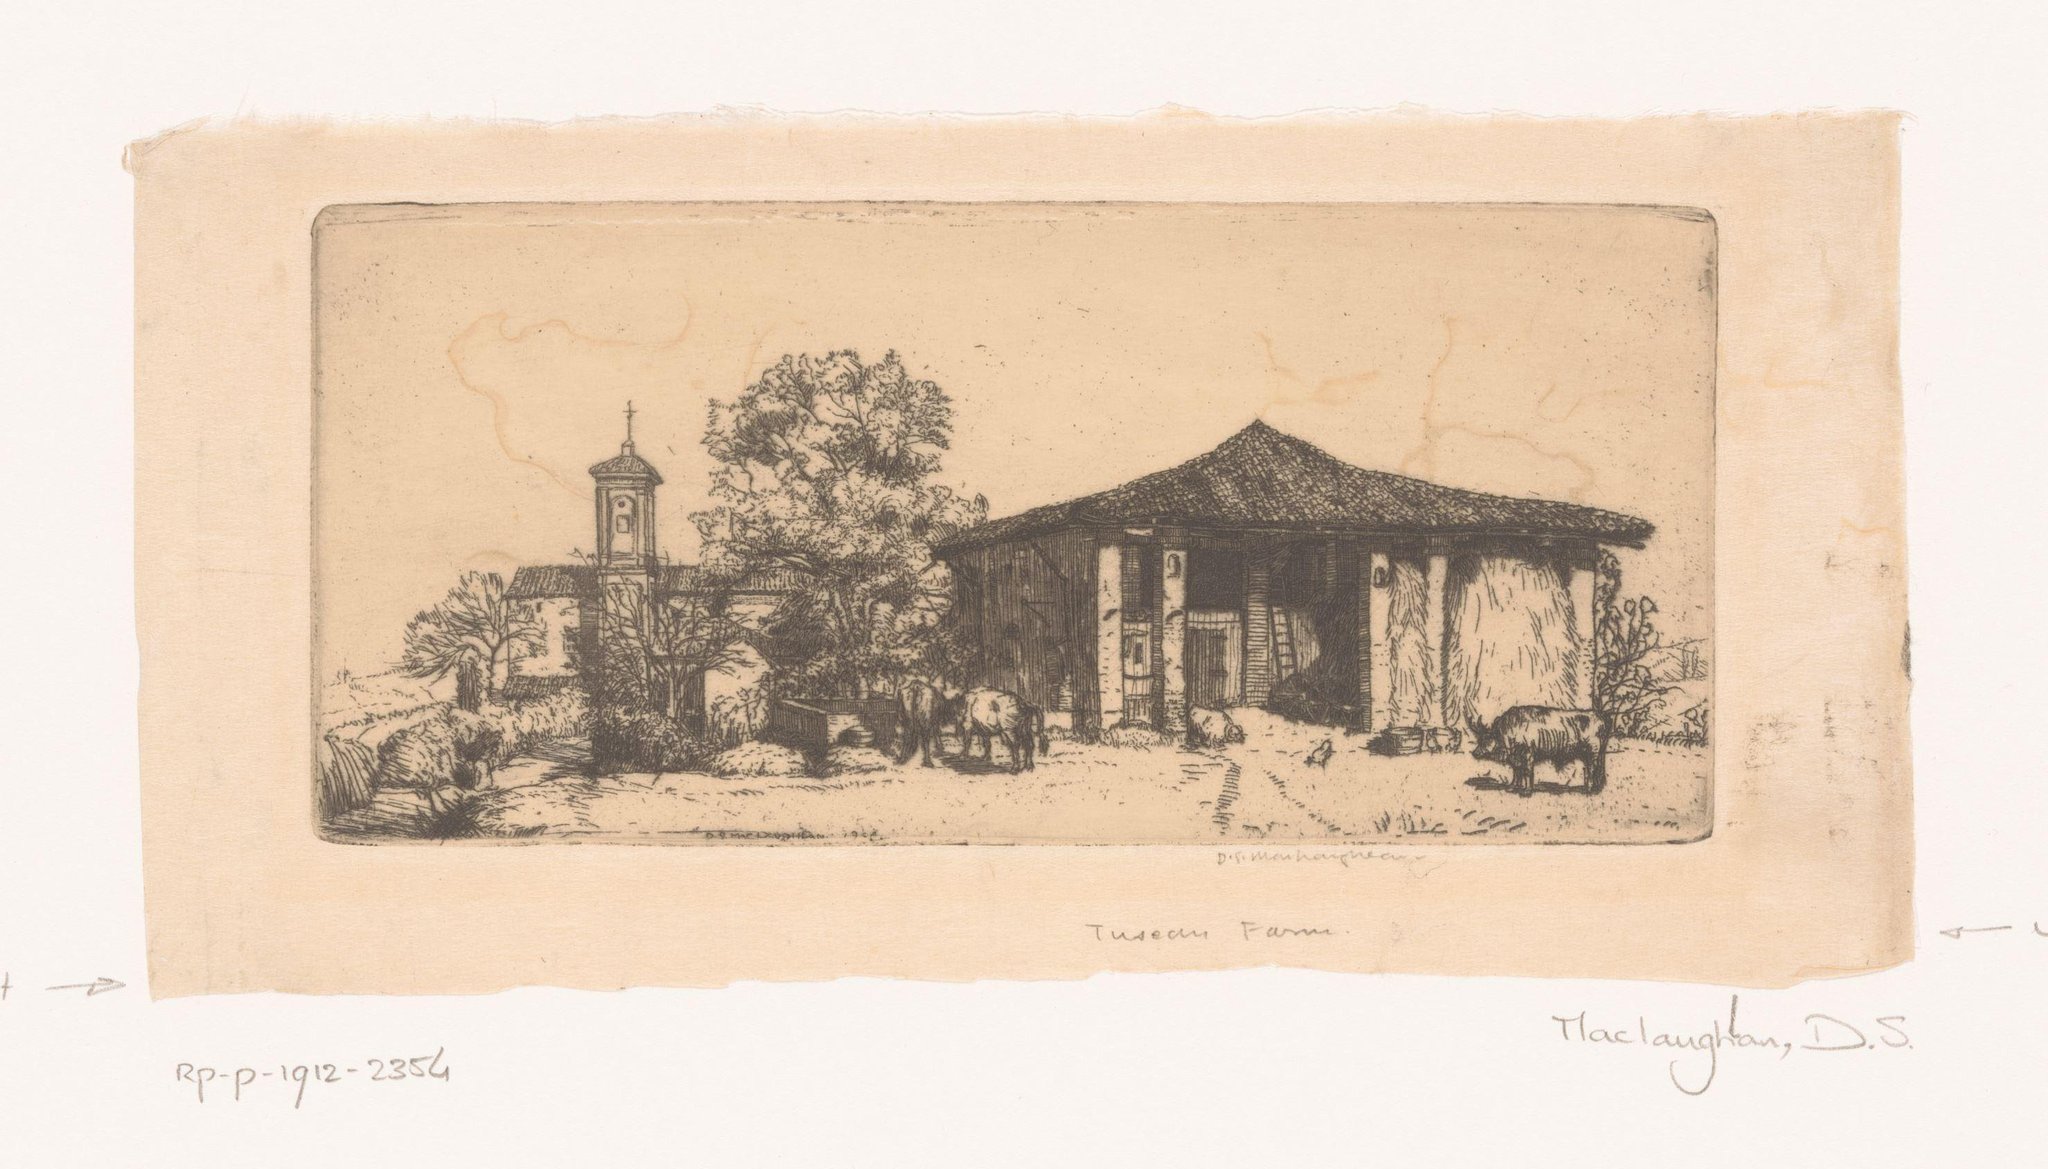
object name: print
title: Toscaanse boerderij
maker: donald shaw maclaughlan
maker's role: painter, print maker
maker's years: 1876-1938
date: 1904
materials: paper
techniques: drypoint, etching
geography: italy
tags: farm or solitary house in landscape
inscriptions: collector's mark: Lugt 2228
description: Een Toscaanse boerderij, op de voorgrond een paar beesten, achter het huis een kerkje.